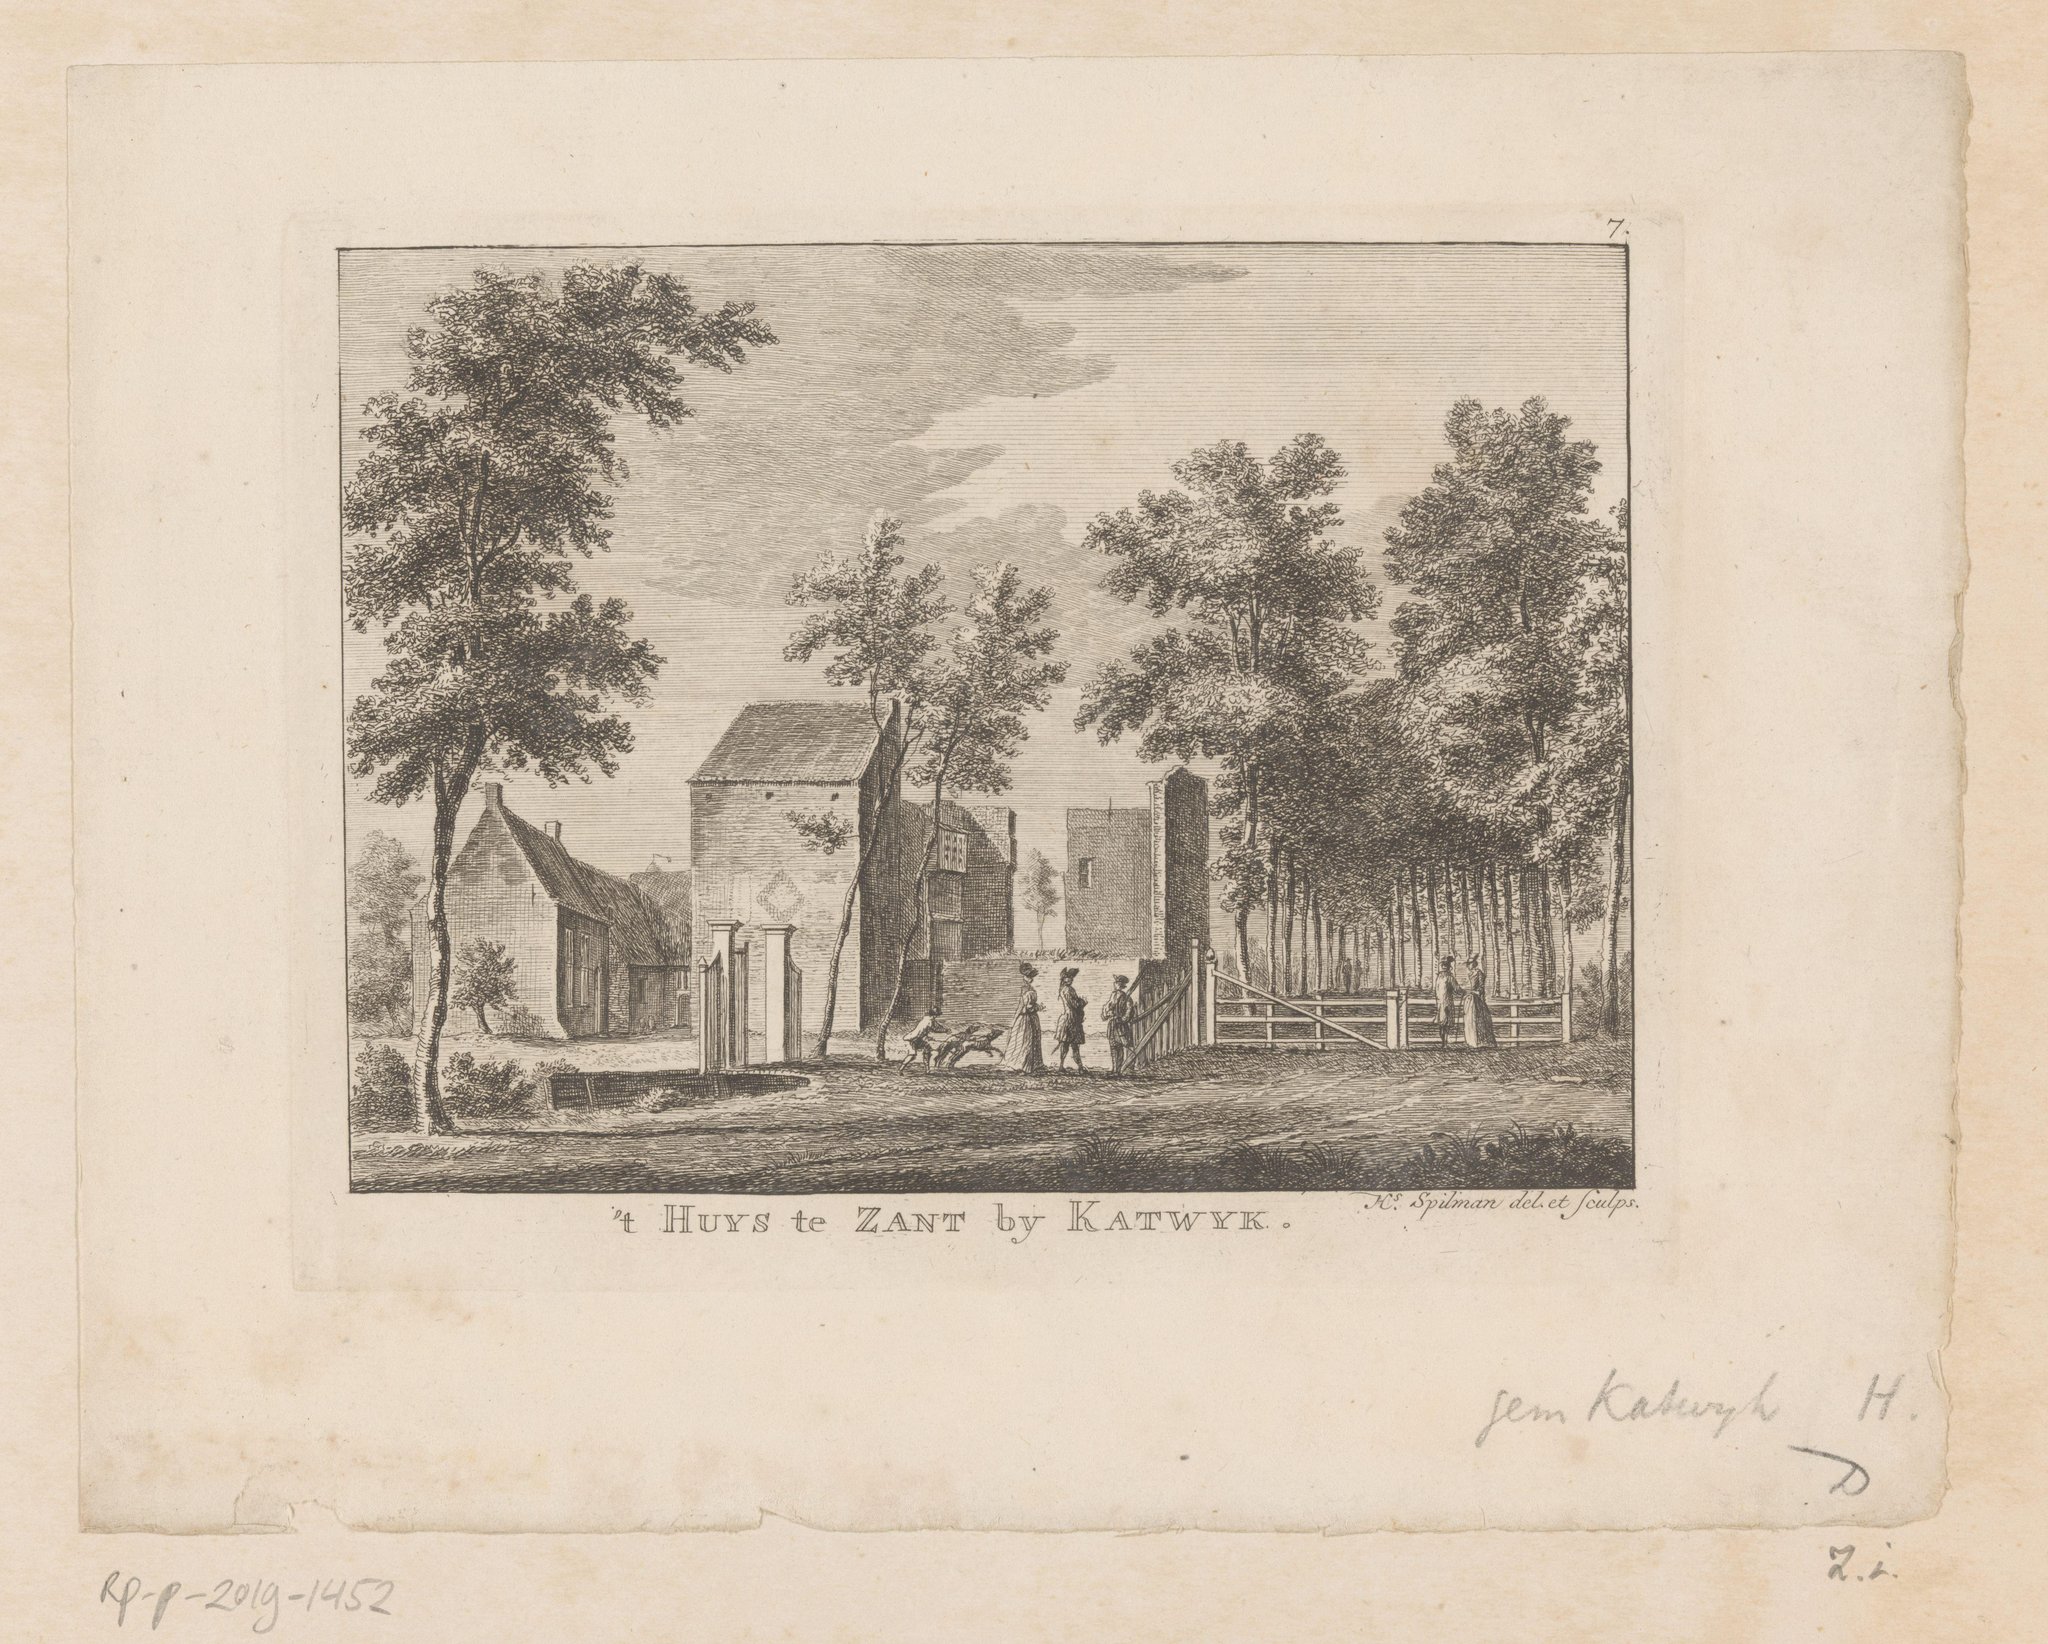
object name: print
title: 't Huys te Zant by Katwyk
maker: hendrik spilman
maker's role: draughtsman, painter, print maker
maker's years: 1721-1784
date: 1742-1784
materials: paper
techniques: etching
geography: haarlem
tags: landscape with ruins (+ city(-scape) with figures, staffage), ruin of a dwelling, house, castle, etc.